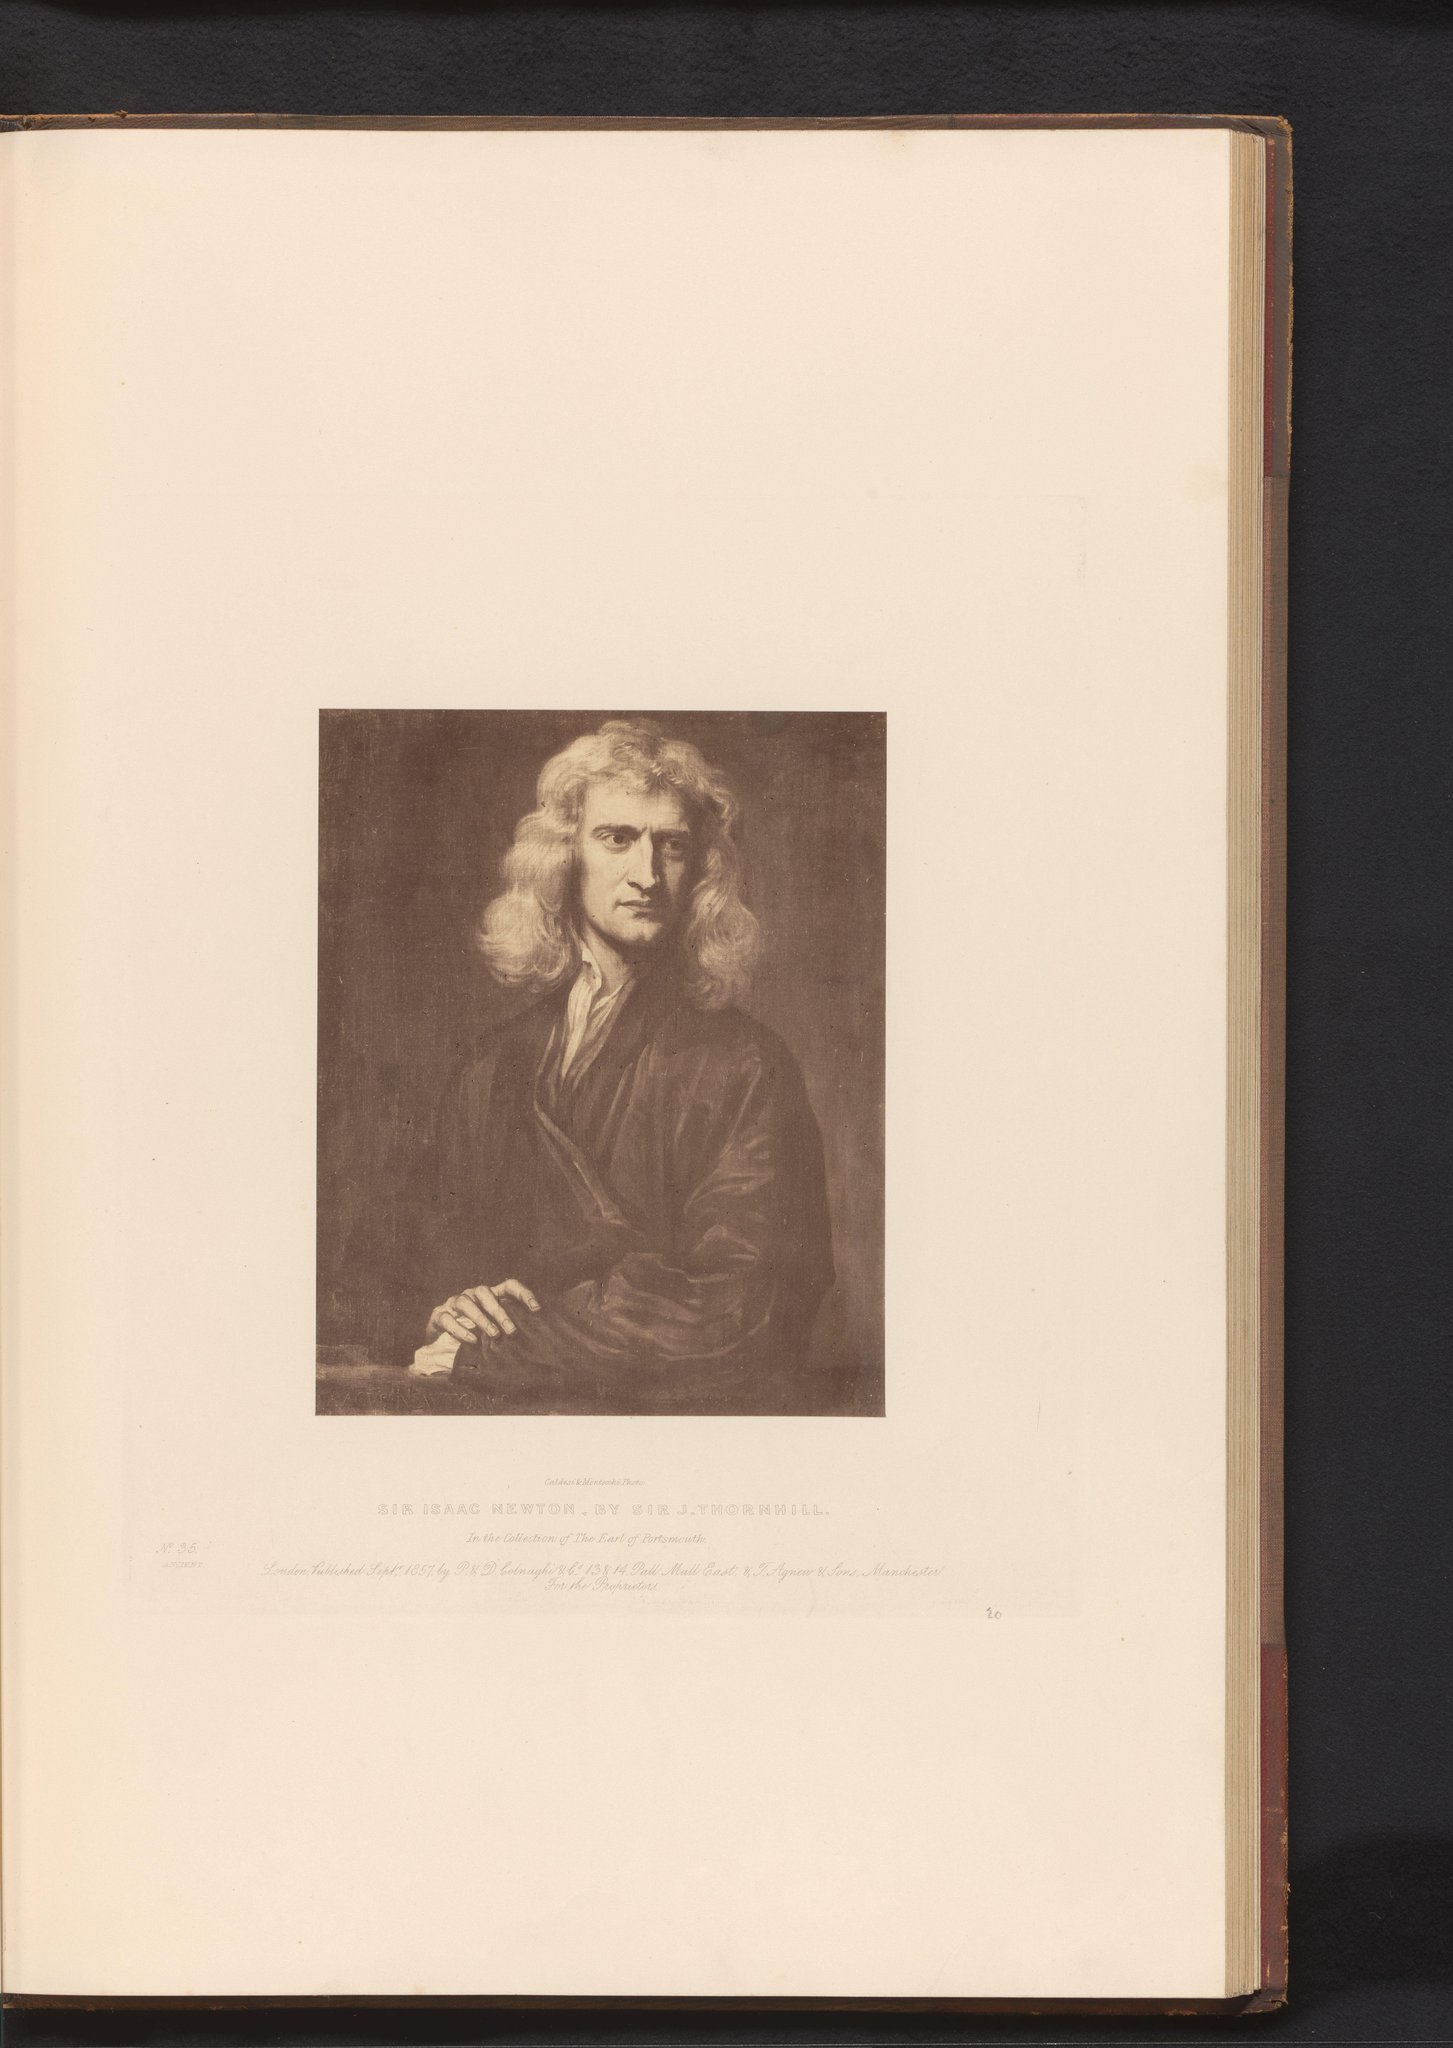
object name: page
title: Fotoreproductie van een schilderij van een portret van Isaac Newton door James Thornhill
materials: photographic support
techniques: albumen print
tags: london, physicist, historical persons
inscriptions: number: ‘20’, number: ‘No. 35./ MODERN.’, inscription: ‘In the Collection of The Earl of Portsmouth./ London, Published Septr, 1857, by P. & D. Colnaghi & Co, 13 & 14, Pall Mall East & T. Agneur & Sons, Manchester./ For the Proprietors.’